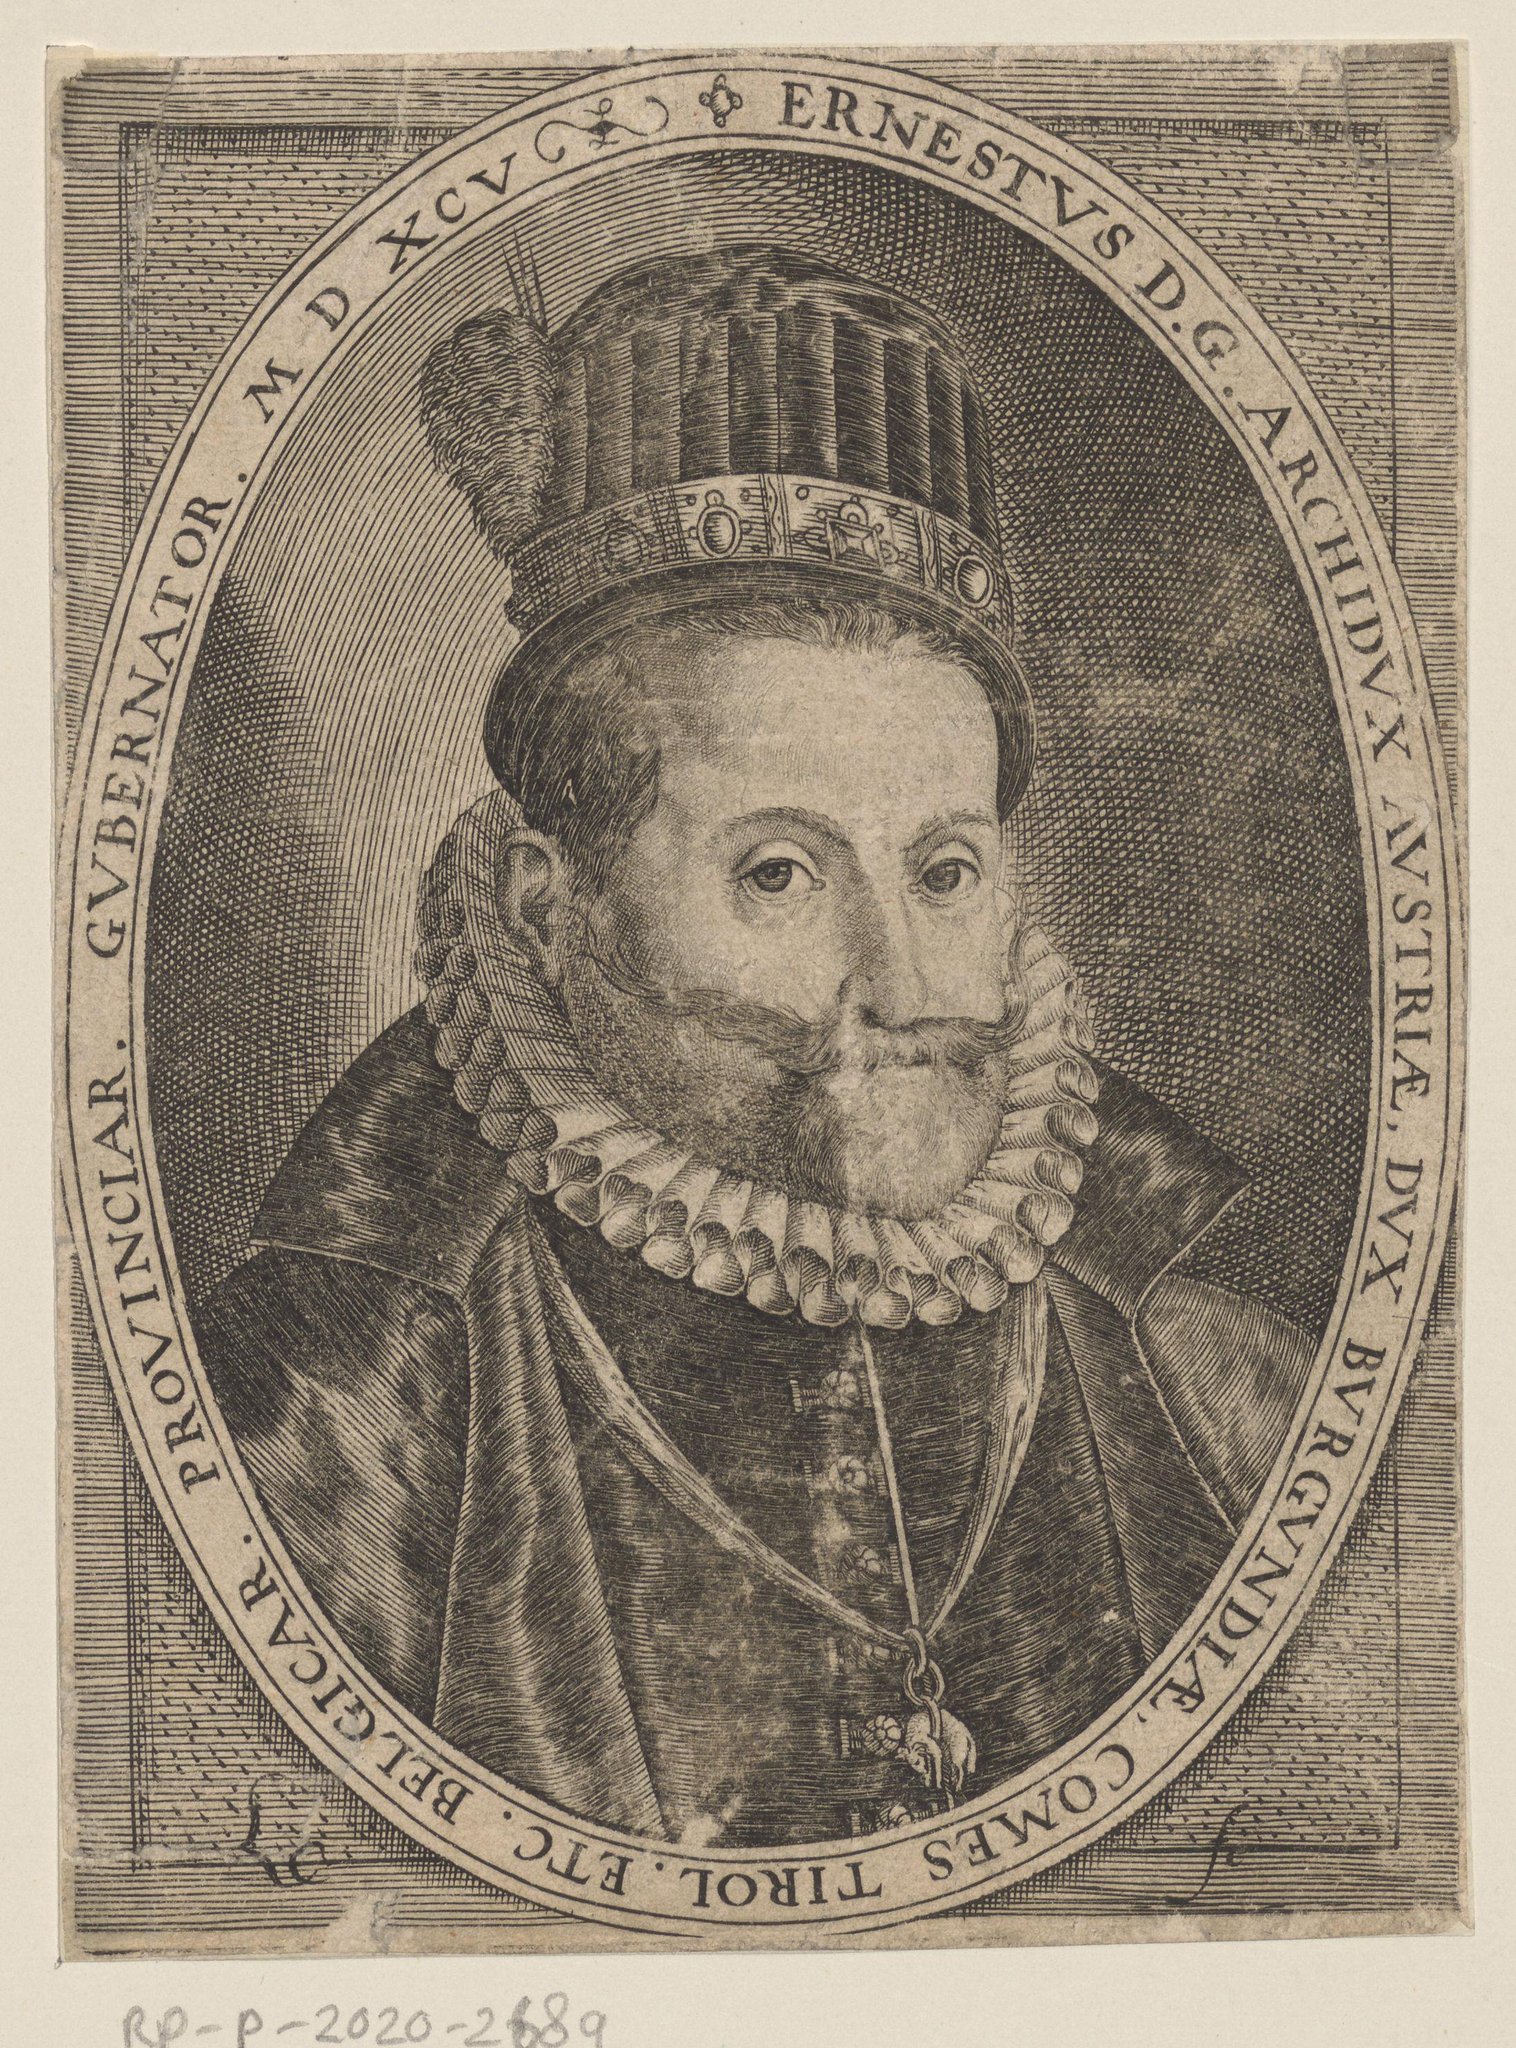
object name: book illustration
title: Portret van Ernst, aartshertog van Oostenrijk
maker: lambert cornelisz.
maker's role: draughtsman, print maker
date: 1616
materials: paper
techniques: engraving, letterpress printing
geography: amsterdam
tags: historical persons, knighthood order of the golden fleece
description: Prent waarschijnlijk uit: Baudartius, Willem. Afbeeldinge ende beschryvinghe van alle de veldslagen, belegeringen ende and're notabele geschiedenissen ghevallen in de Nederlanden (...). Amsterdam: Michiel Colijn, 1616.